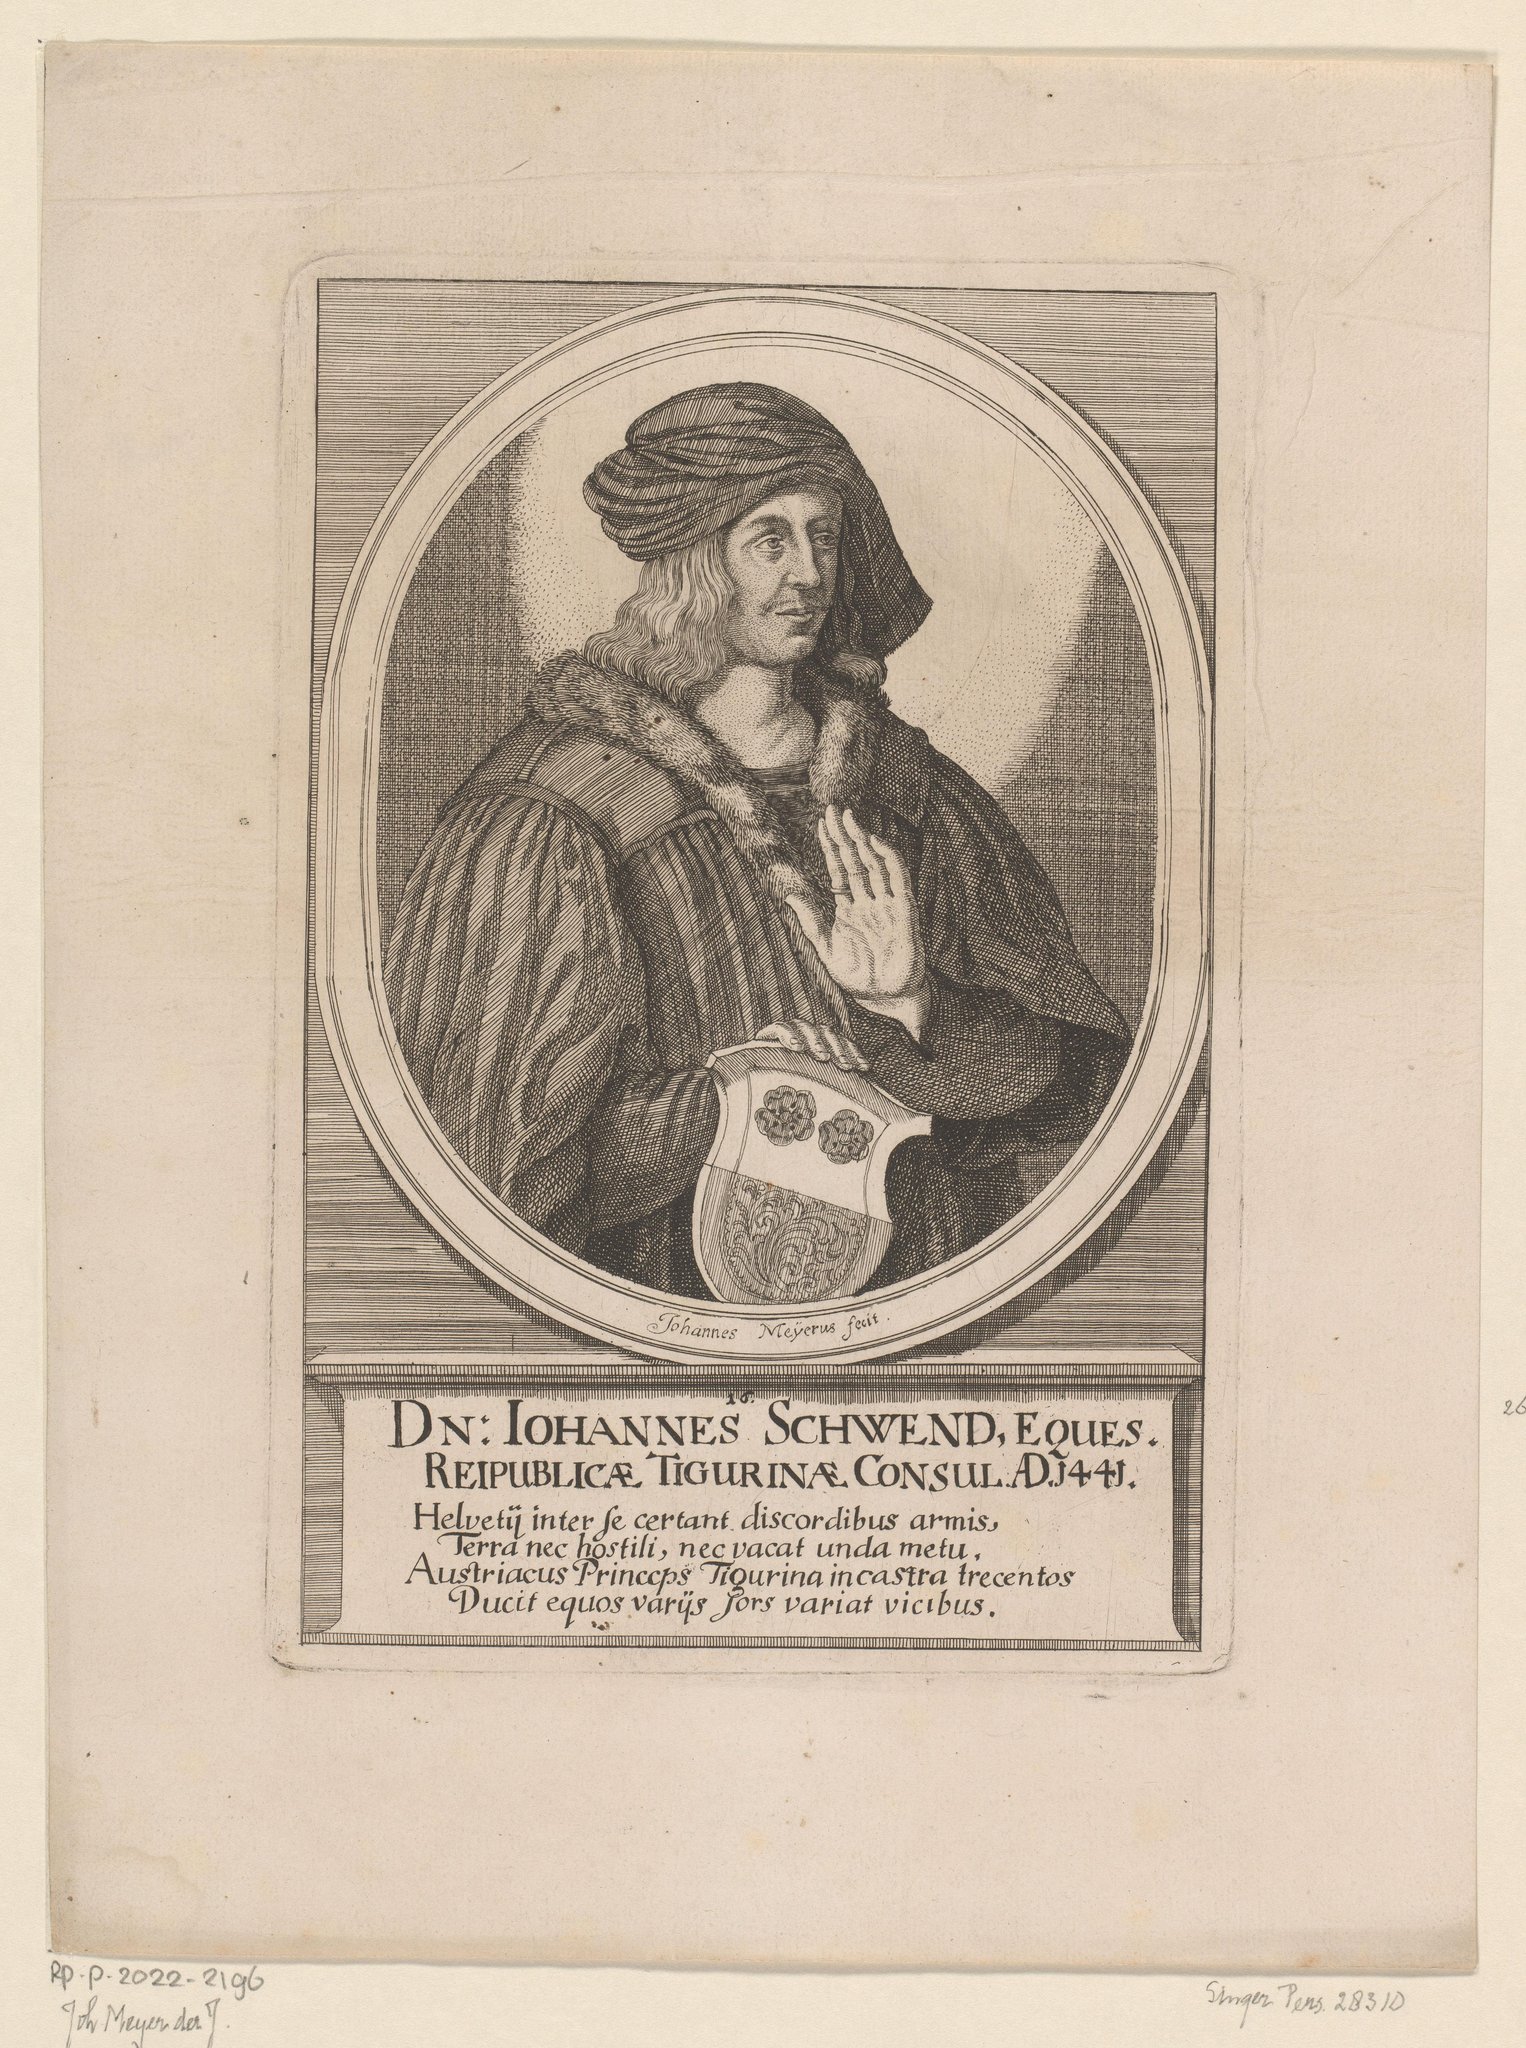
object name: print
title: Portretten van burgemeesters van Zürich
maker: johannes meyer (ii)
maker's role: print maker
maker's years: 1655-1712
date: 1665-1712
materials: paper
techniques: engraving, etching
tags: mayor, burgomaster, historical persons, armorial bearing, heraldry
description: Met zesregelig onderschrift in het Latijn. Onderaan de ovale omlijsting genummerd: 16.